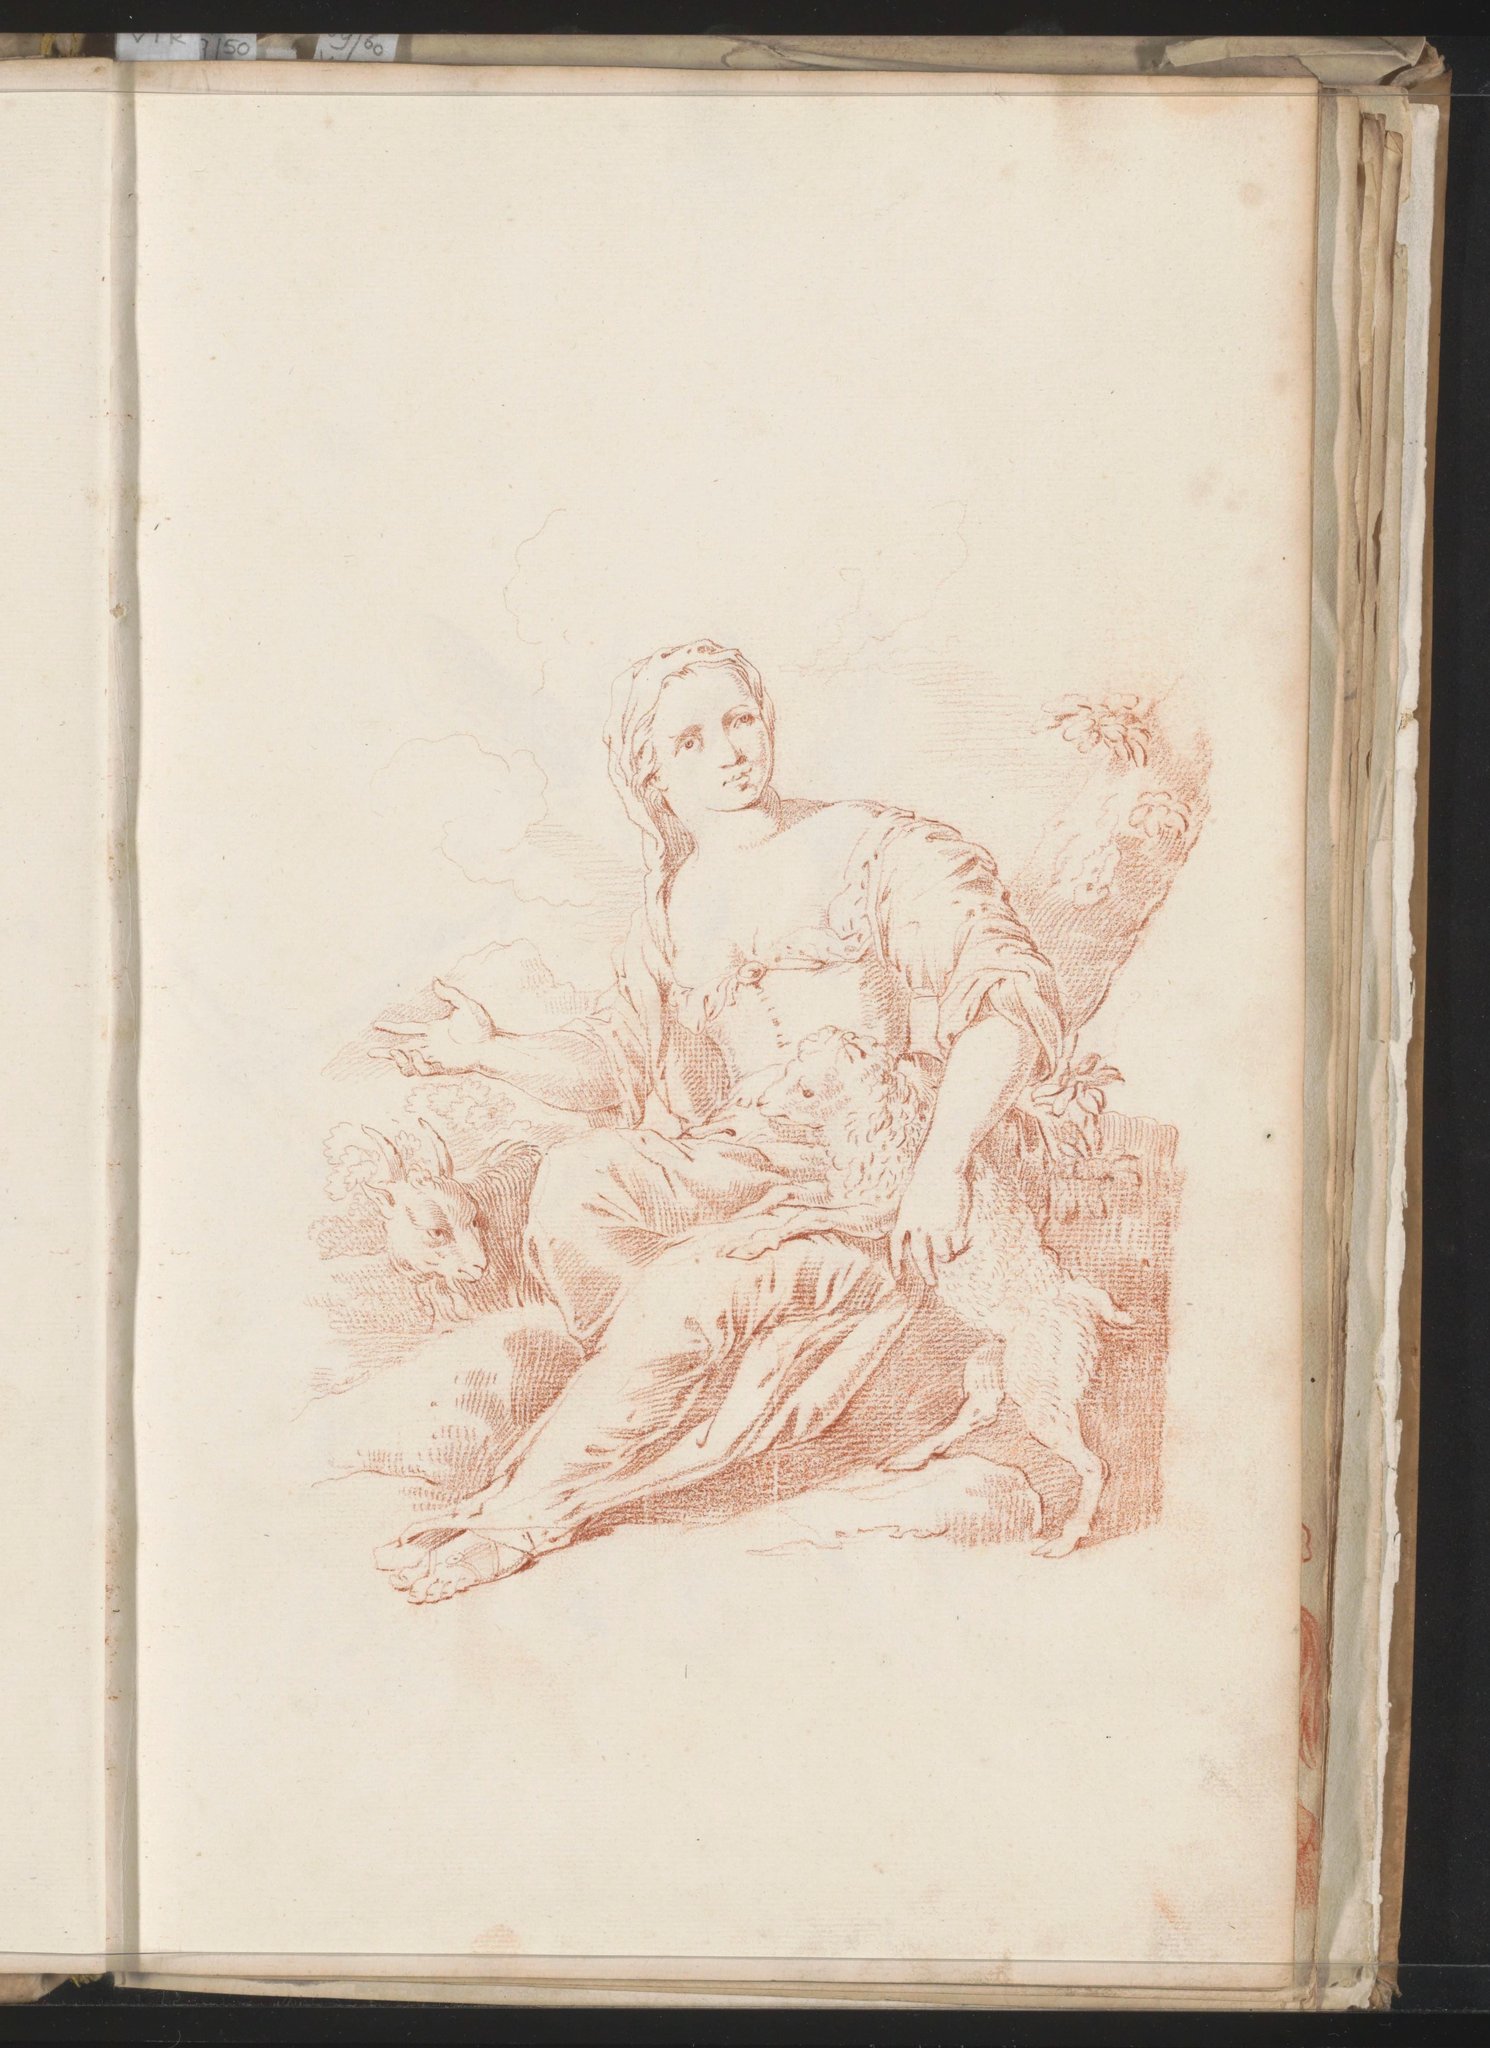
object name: sketchbook leaf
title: Vrouw met een lam en geit in een landschap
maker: jacob toorenvliet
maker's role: draughtsman, painter, print maker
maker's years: 1640-1719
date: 1701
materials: chalk, paper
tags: sitting figure, lamb, goat, landscapes (+ landscape with figures, staffage)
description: Blad 23 recto uit een schetsboek met 63 bladen.